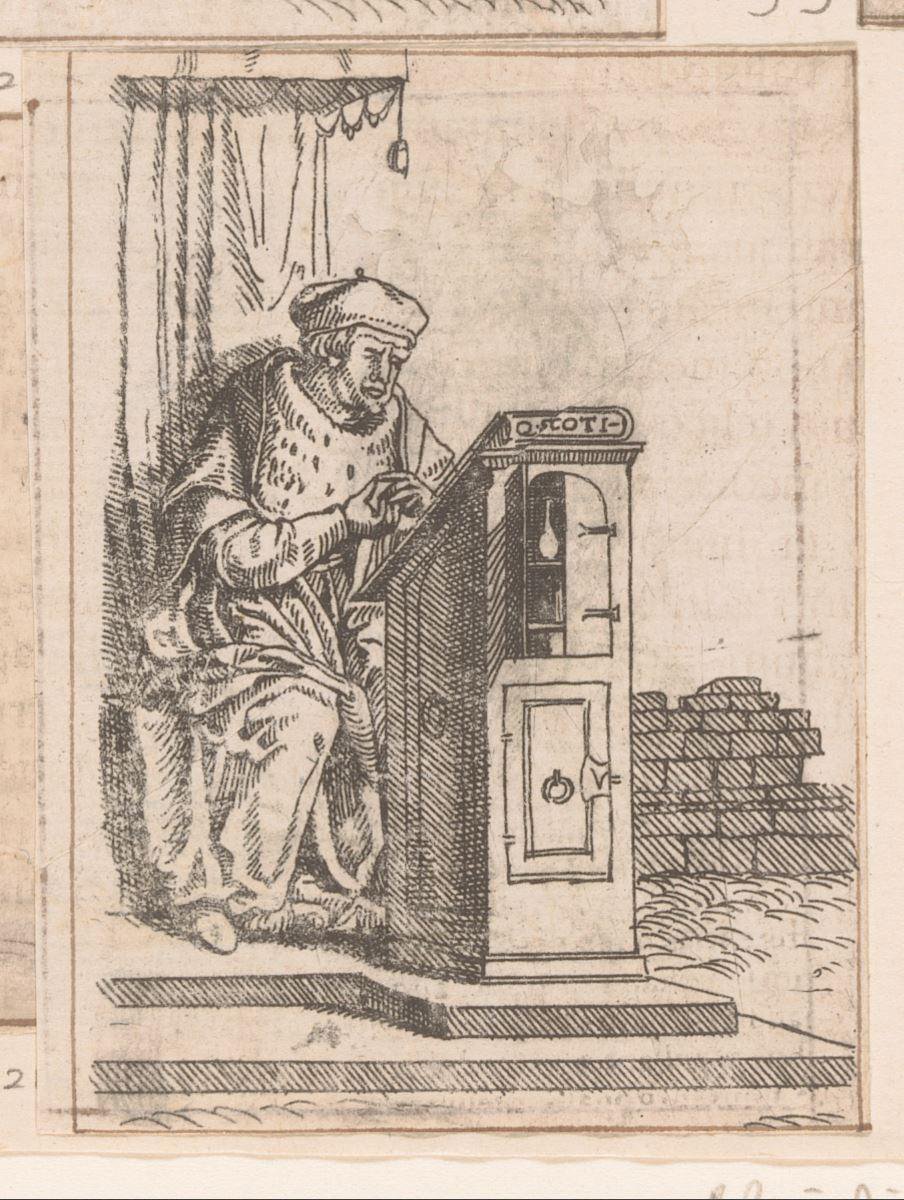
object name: print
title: Scholasticus overweegt een redenering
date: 1516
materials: paper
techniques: etching, letterpress printing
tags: desiderius erasmus, scholar in his study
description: Prent afkomstig uit: Erasmus, Desiderius. Morias enkomion (...). Bazel: Johann Rudolf Genath, 1676. De prenten hierin zijn naar tekeningen die Hans en Ambrosius Holbein maakten voor de theoloog Oswald Myconius in diens uitgave van de Moriae encomium (Lof der Zotheid) van 1516.